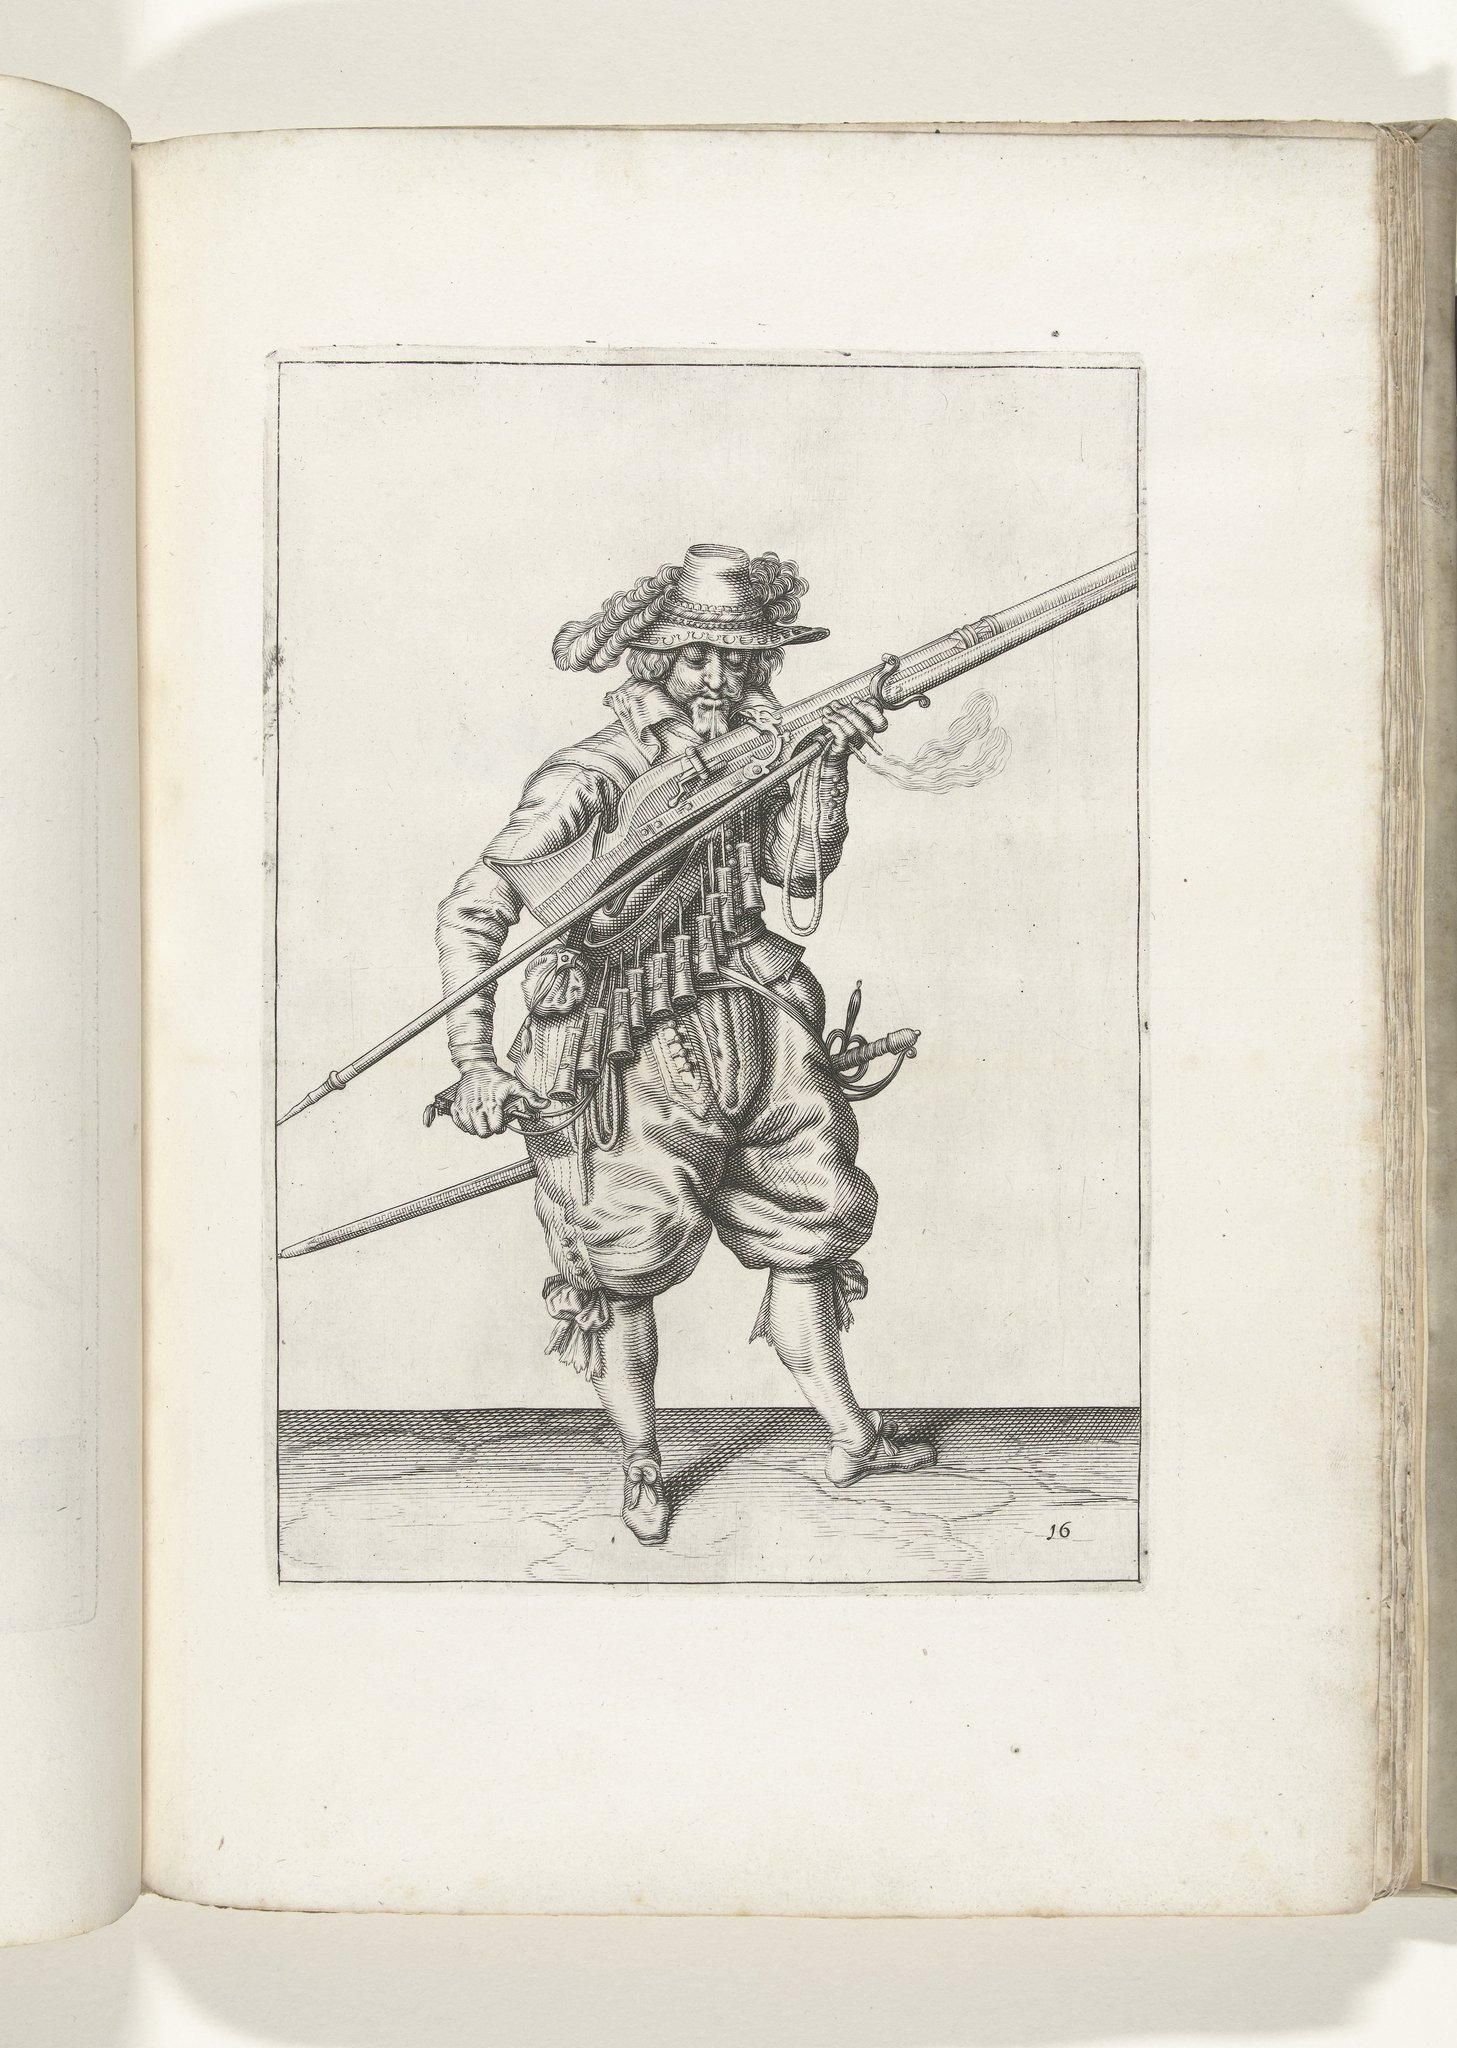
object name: print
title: Soldaat die vonken wegblaast van de pan van zijn musket (nr. 16), ca. 1600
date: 1597-1607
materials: paper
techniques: engraving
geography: the hague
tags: the hague, maurice (prince of orange), handling of weapons ~ military training, weapons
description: Een soldaat, ten voeten uit, naar rechts, die een musket (een bepaald type vuurwapen) bij zijn mond houdt en over de pan (het kruitreservoir) blaast (nr. 16), ca. 1600. In zijn linkerhand behalve het musket ook een furket (musketvork) en een brandende lont. In zijn rechterhand een kruitfles. Plaat 16 in de instructies voor het hanteren van het musket: Corte onderrechtinghe op de figuerliicke afbeeldinghe, soo veel aengaet het recht ghebruyck vant Musquet. Onderdeel van de illustraties in: J. de Gheyn, Wapenhandelinghe van Roers Musquetten ende spiessen, 's-Gravenhage, 1607. Krijgswezen rond 1600.